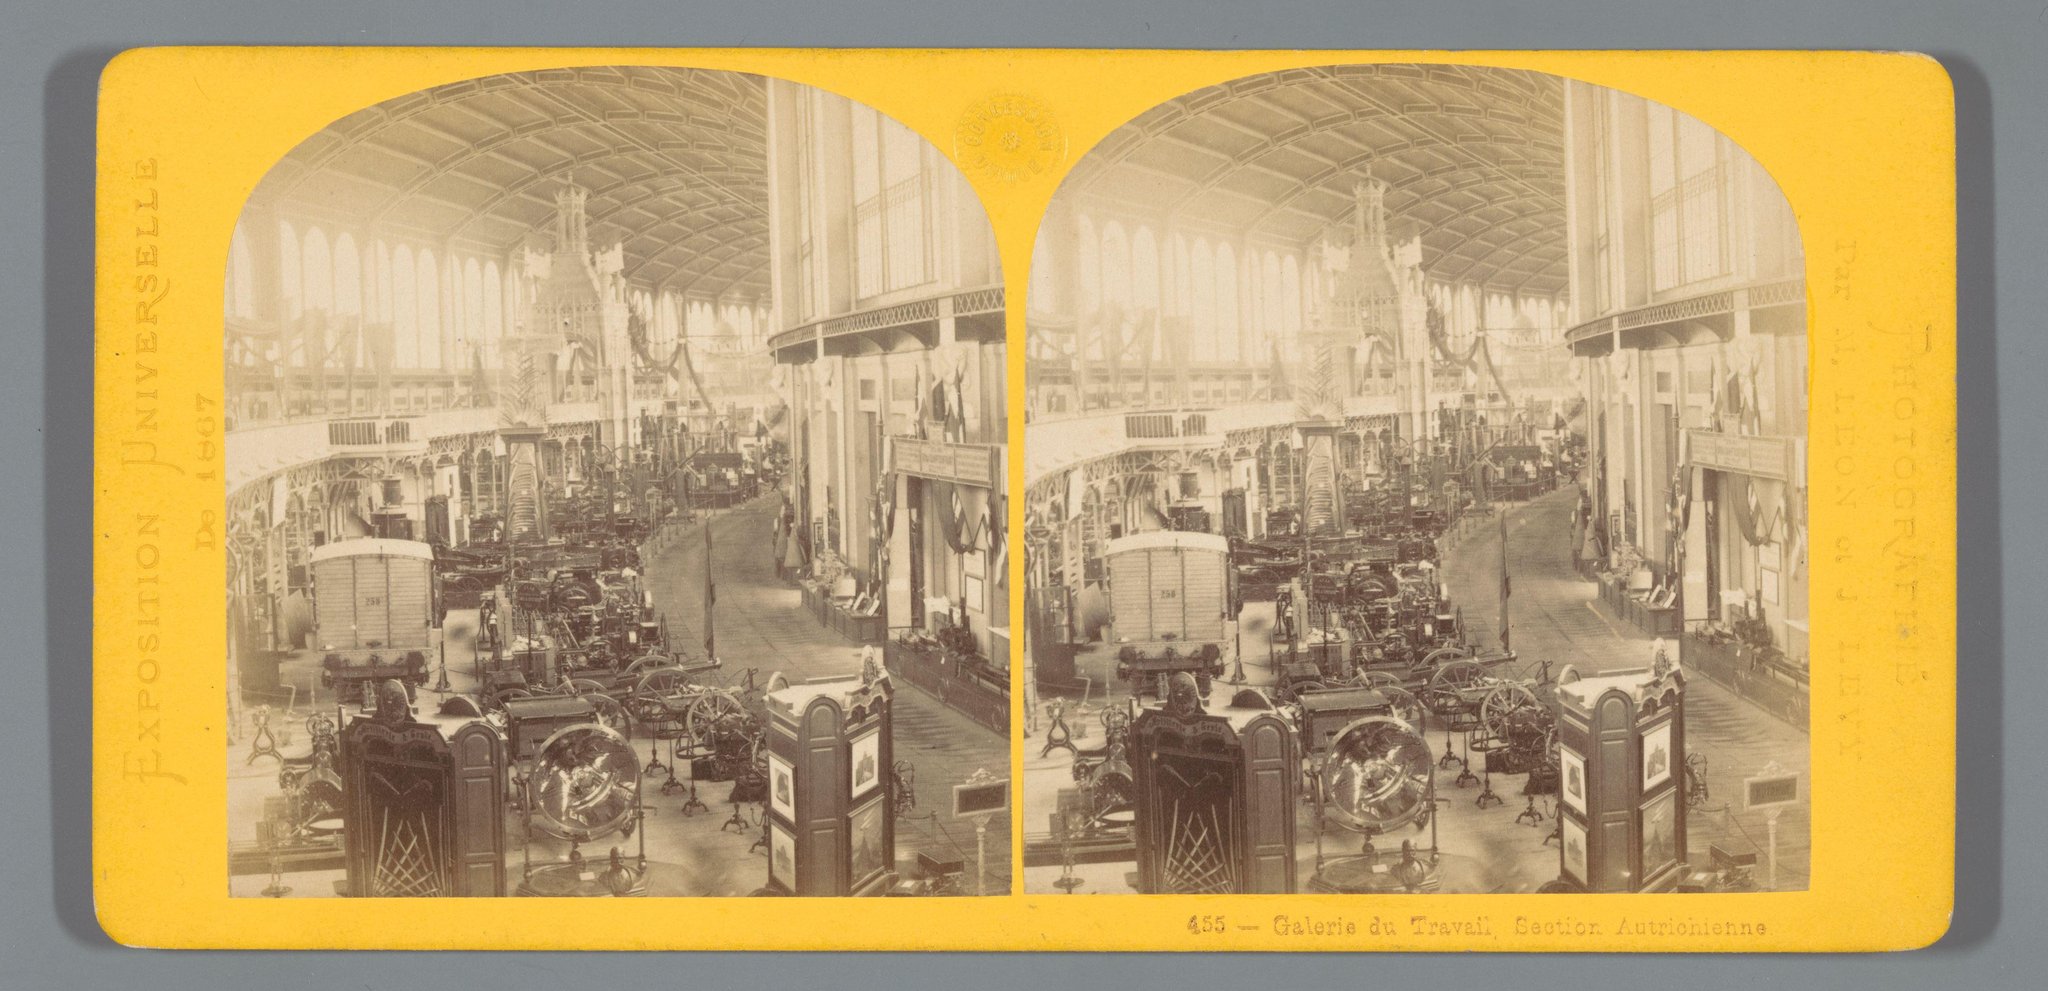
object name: stereograph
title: Exposition Universelle de 1867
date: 1867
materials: cardboard, paper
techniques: albumen print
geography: paris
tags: world fair, world exhibition, paris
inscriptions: check stamp: ‘CONCESSION/ */ UNIQUE’, number: ‘455’, address: ‘(...) 113, Boulevard du Sébastopol, 113/ PARIS (...)’